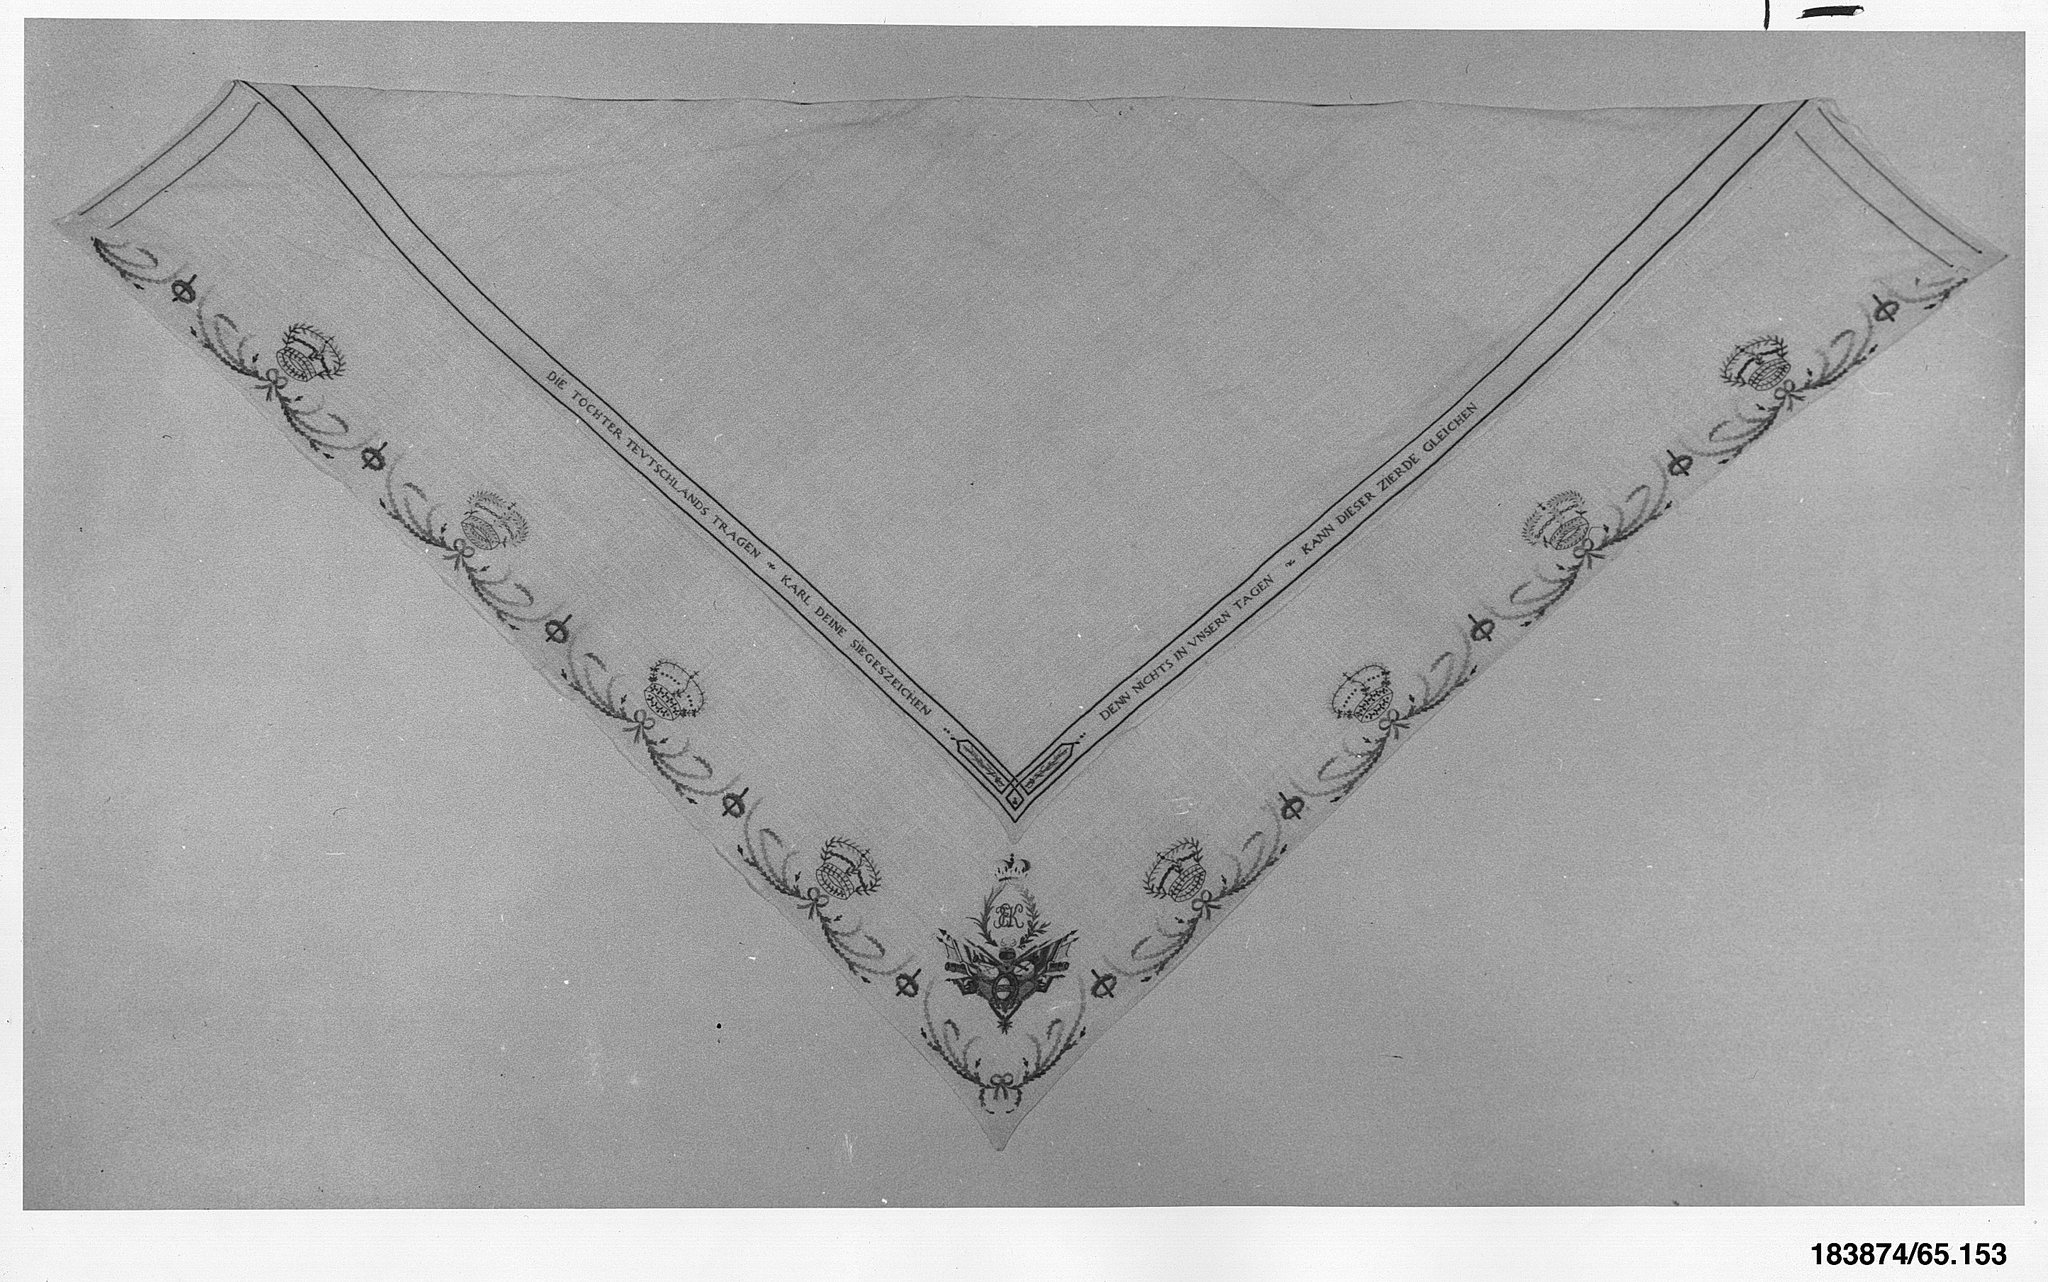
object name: scarf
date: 1809-1810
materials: linen, metal thread, silk